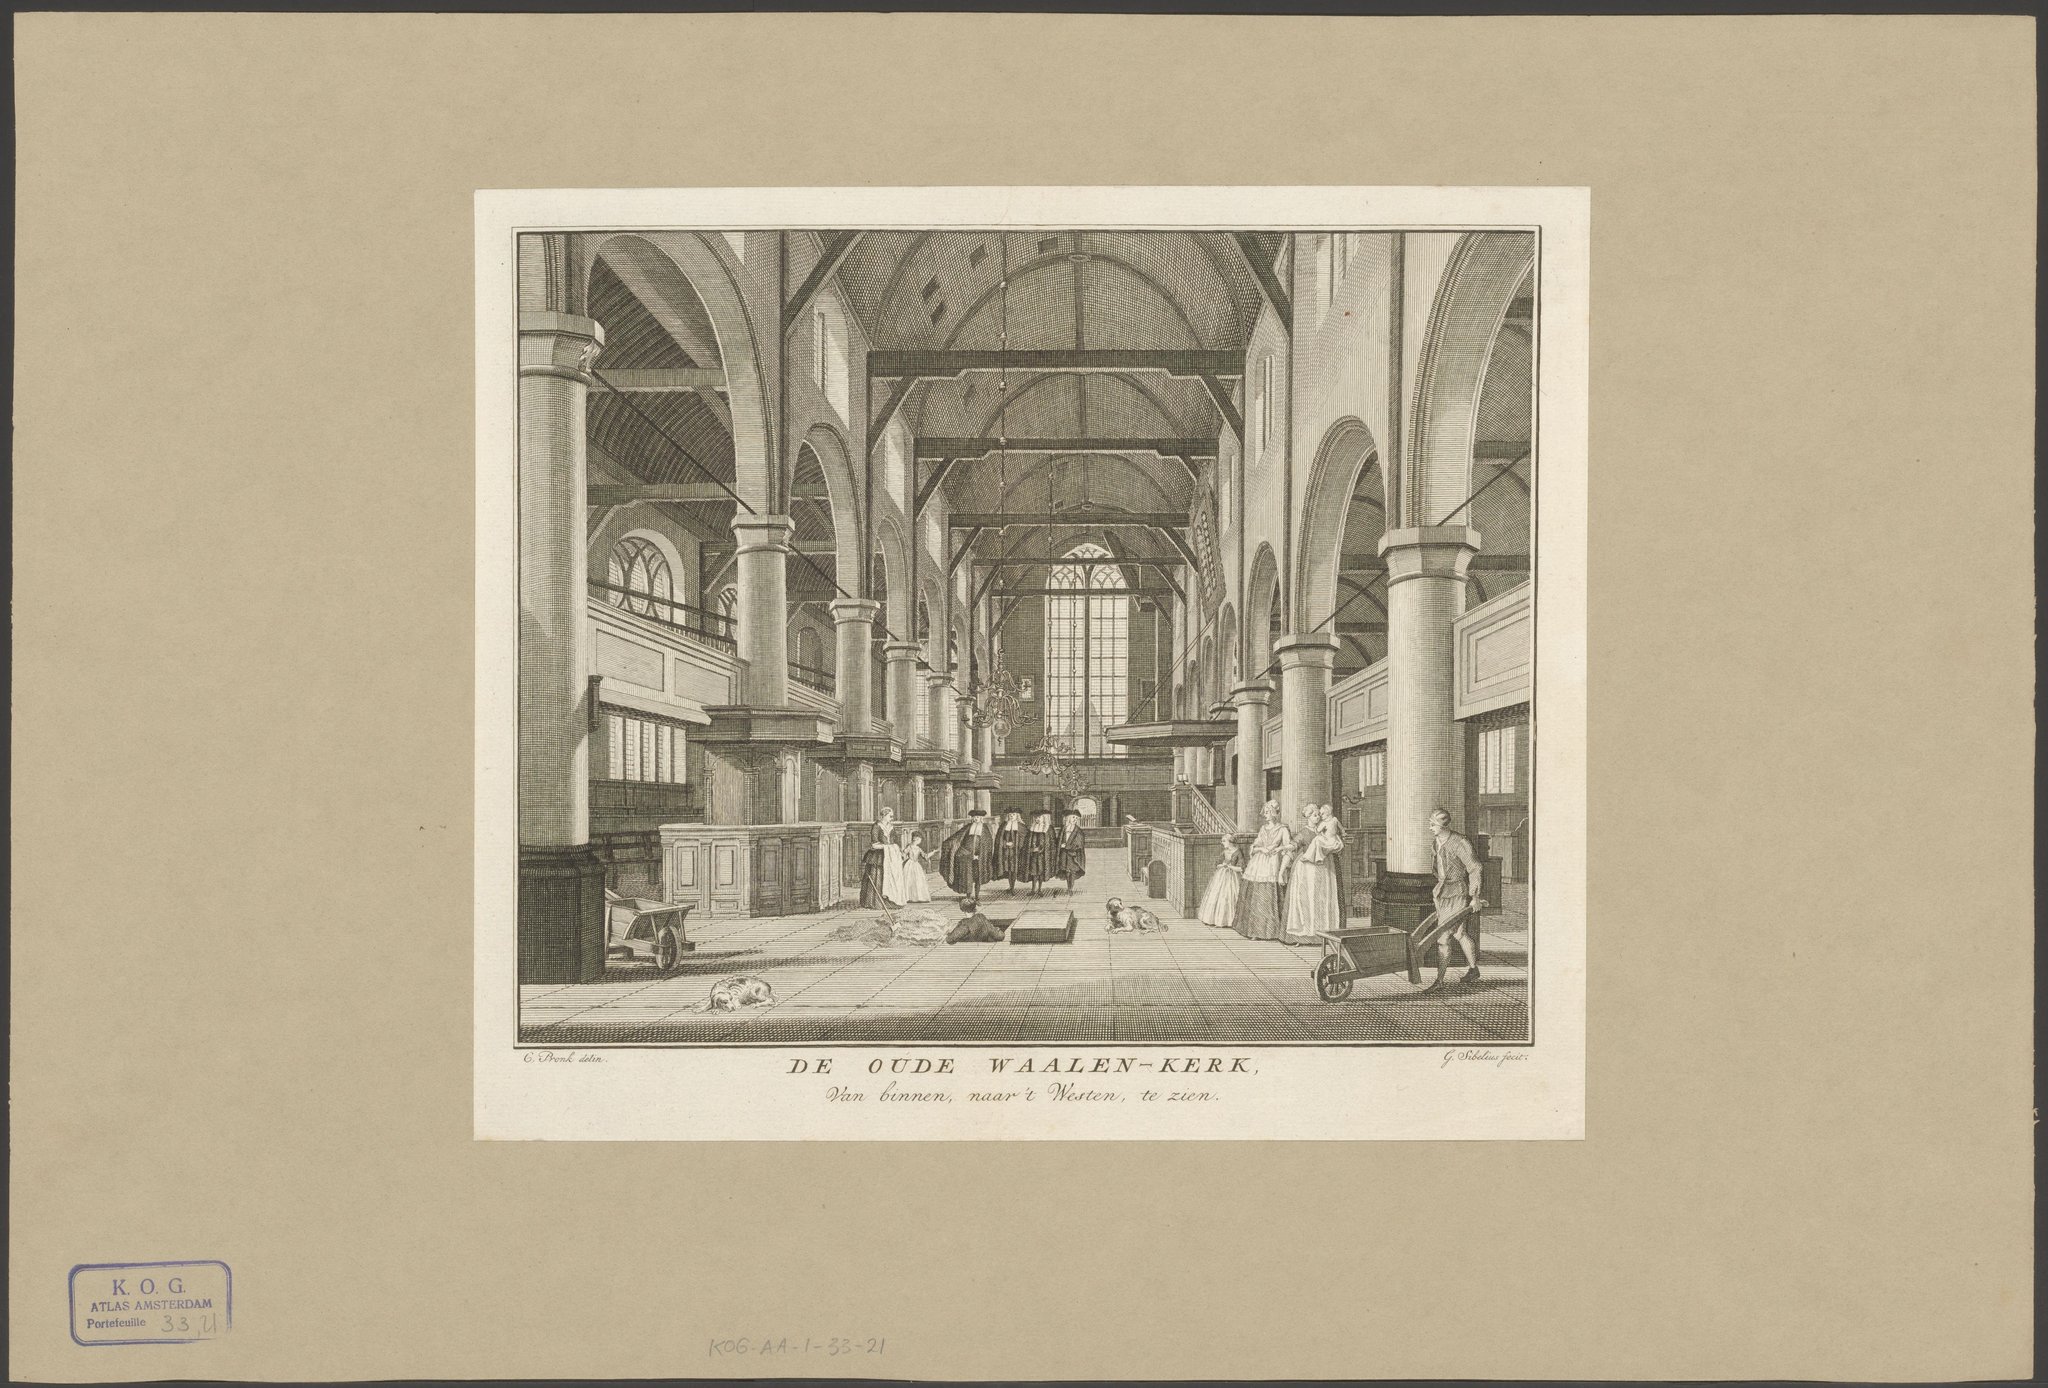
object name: print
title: Interieur van de Waalse Kerk te Amsterdam, gezien richting de hoofdingang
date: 1765-1782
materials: paper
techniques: engraving, etching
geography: harlingen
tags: interior of church, grave digger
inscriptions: collector's mark: Lugt 1641b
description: Prent mogelijk uit: Wagenaar, Jan. Amsterdam, in zyne opkomst, aanwas, geschiedenissen (…). Amsterdam: Isaak Tirion, 1765, dl. 2. Of uit: Verzameling der fraaiste gezigten van Amsterdam in negen en zeventig afbeeldingen. Amsterdam en Harlingen: Petrus Conradi en Volkert van der Plaats, 1782.